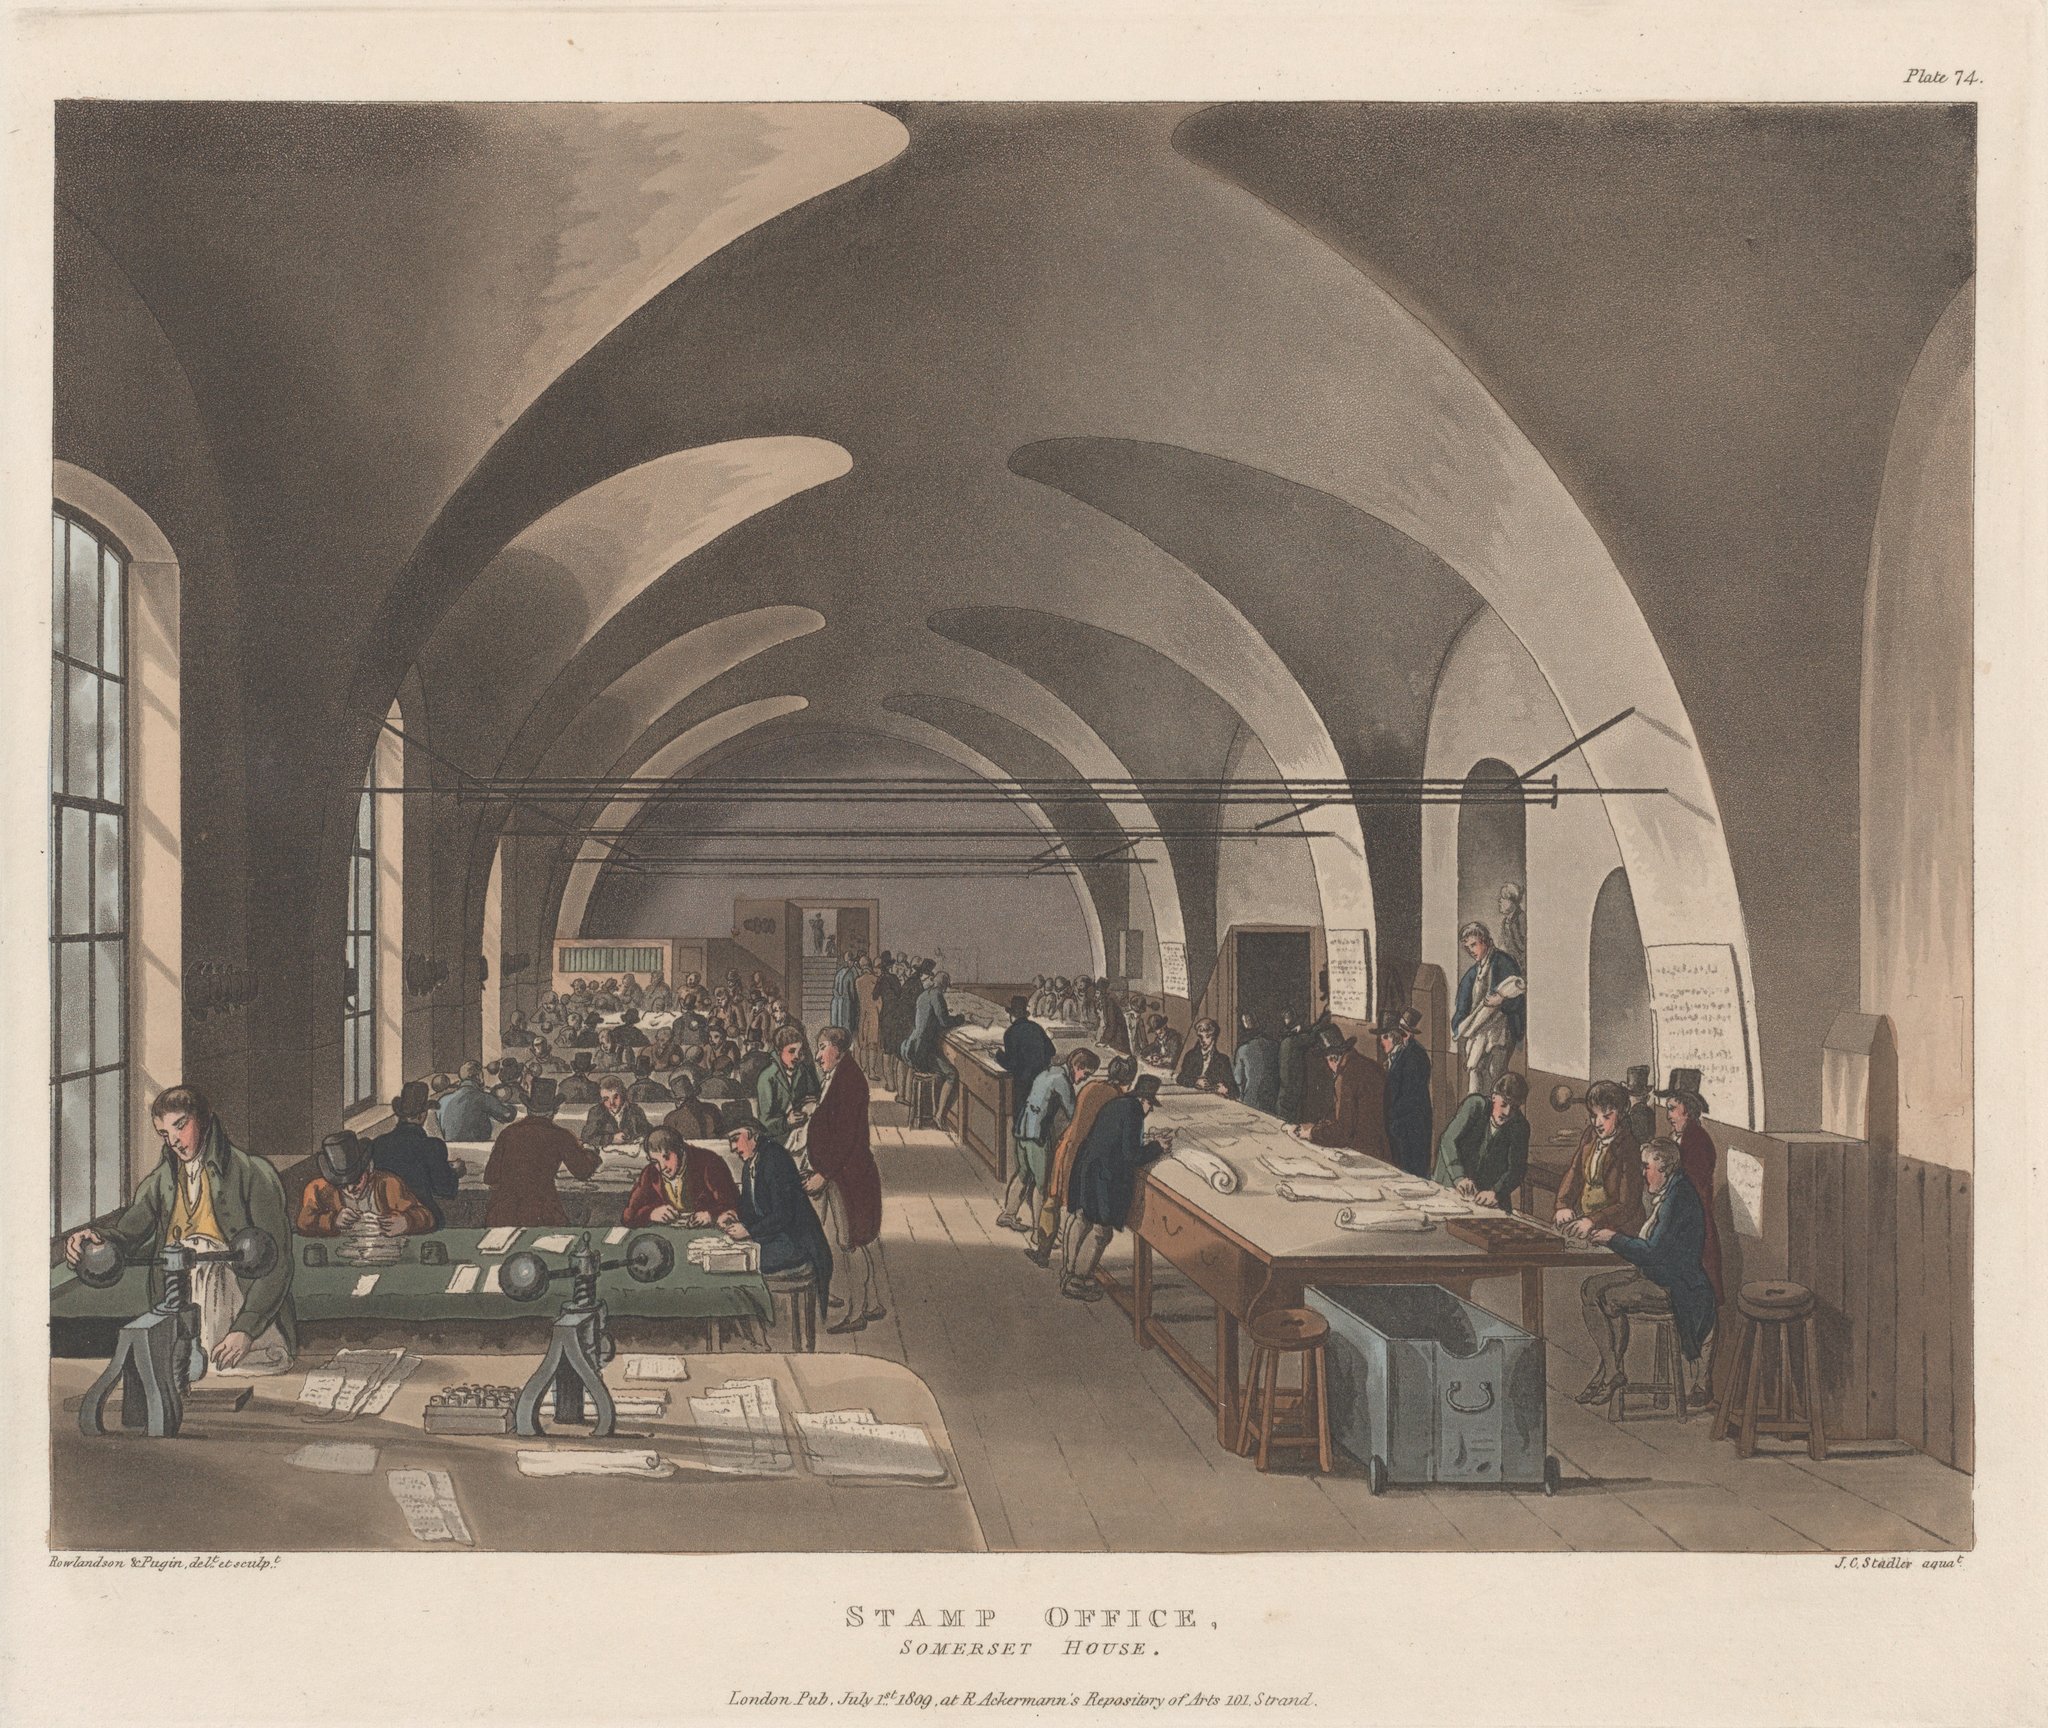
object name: print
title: Stamp Office, Sommerset House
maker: thomas rowlandson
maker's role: artist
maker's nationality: british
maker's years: 1757-1827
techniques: aquatint, etching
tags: interiors,men,working